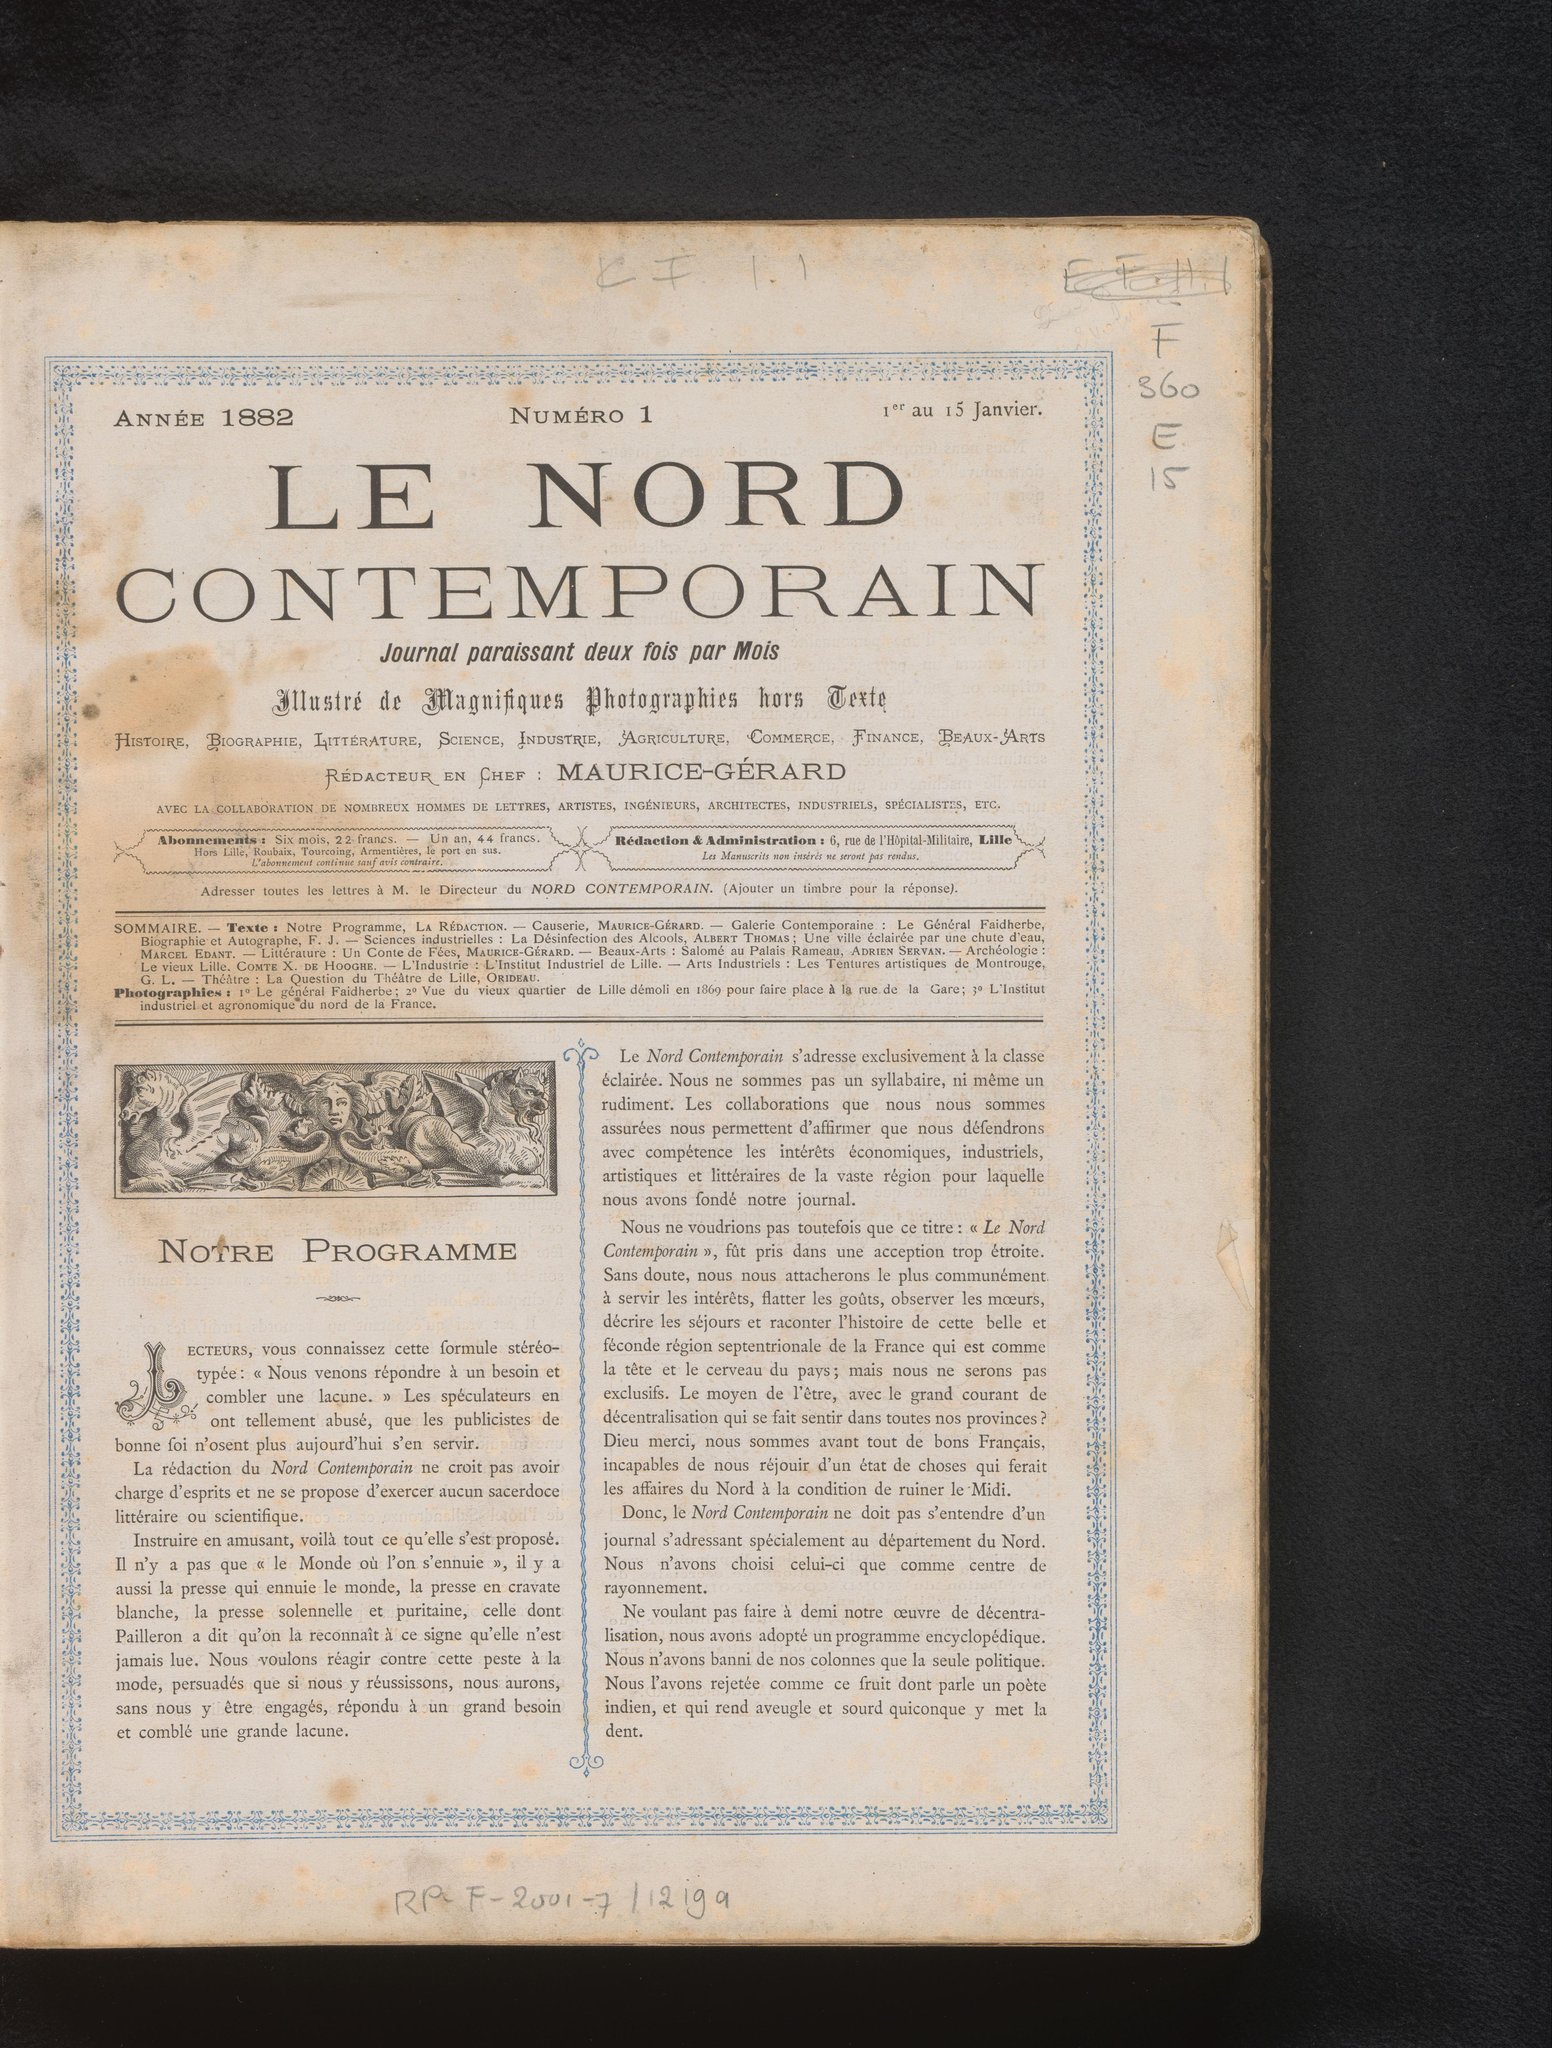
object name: magazine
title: Le Nord contemporain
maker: Anonymous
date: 1882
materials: linen, paper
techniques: decorated paper, printing, woodburytype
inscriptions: date: ‘apr 1999’